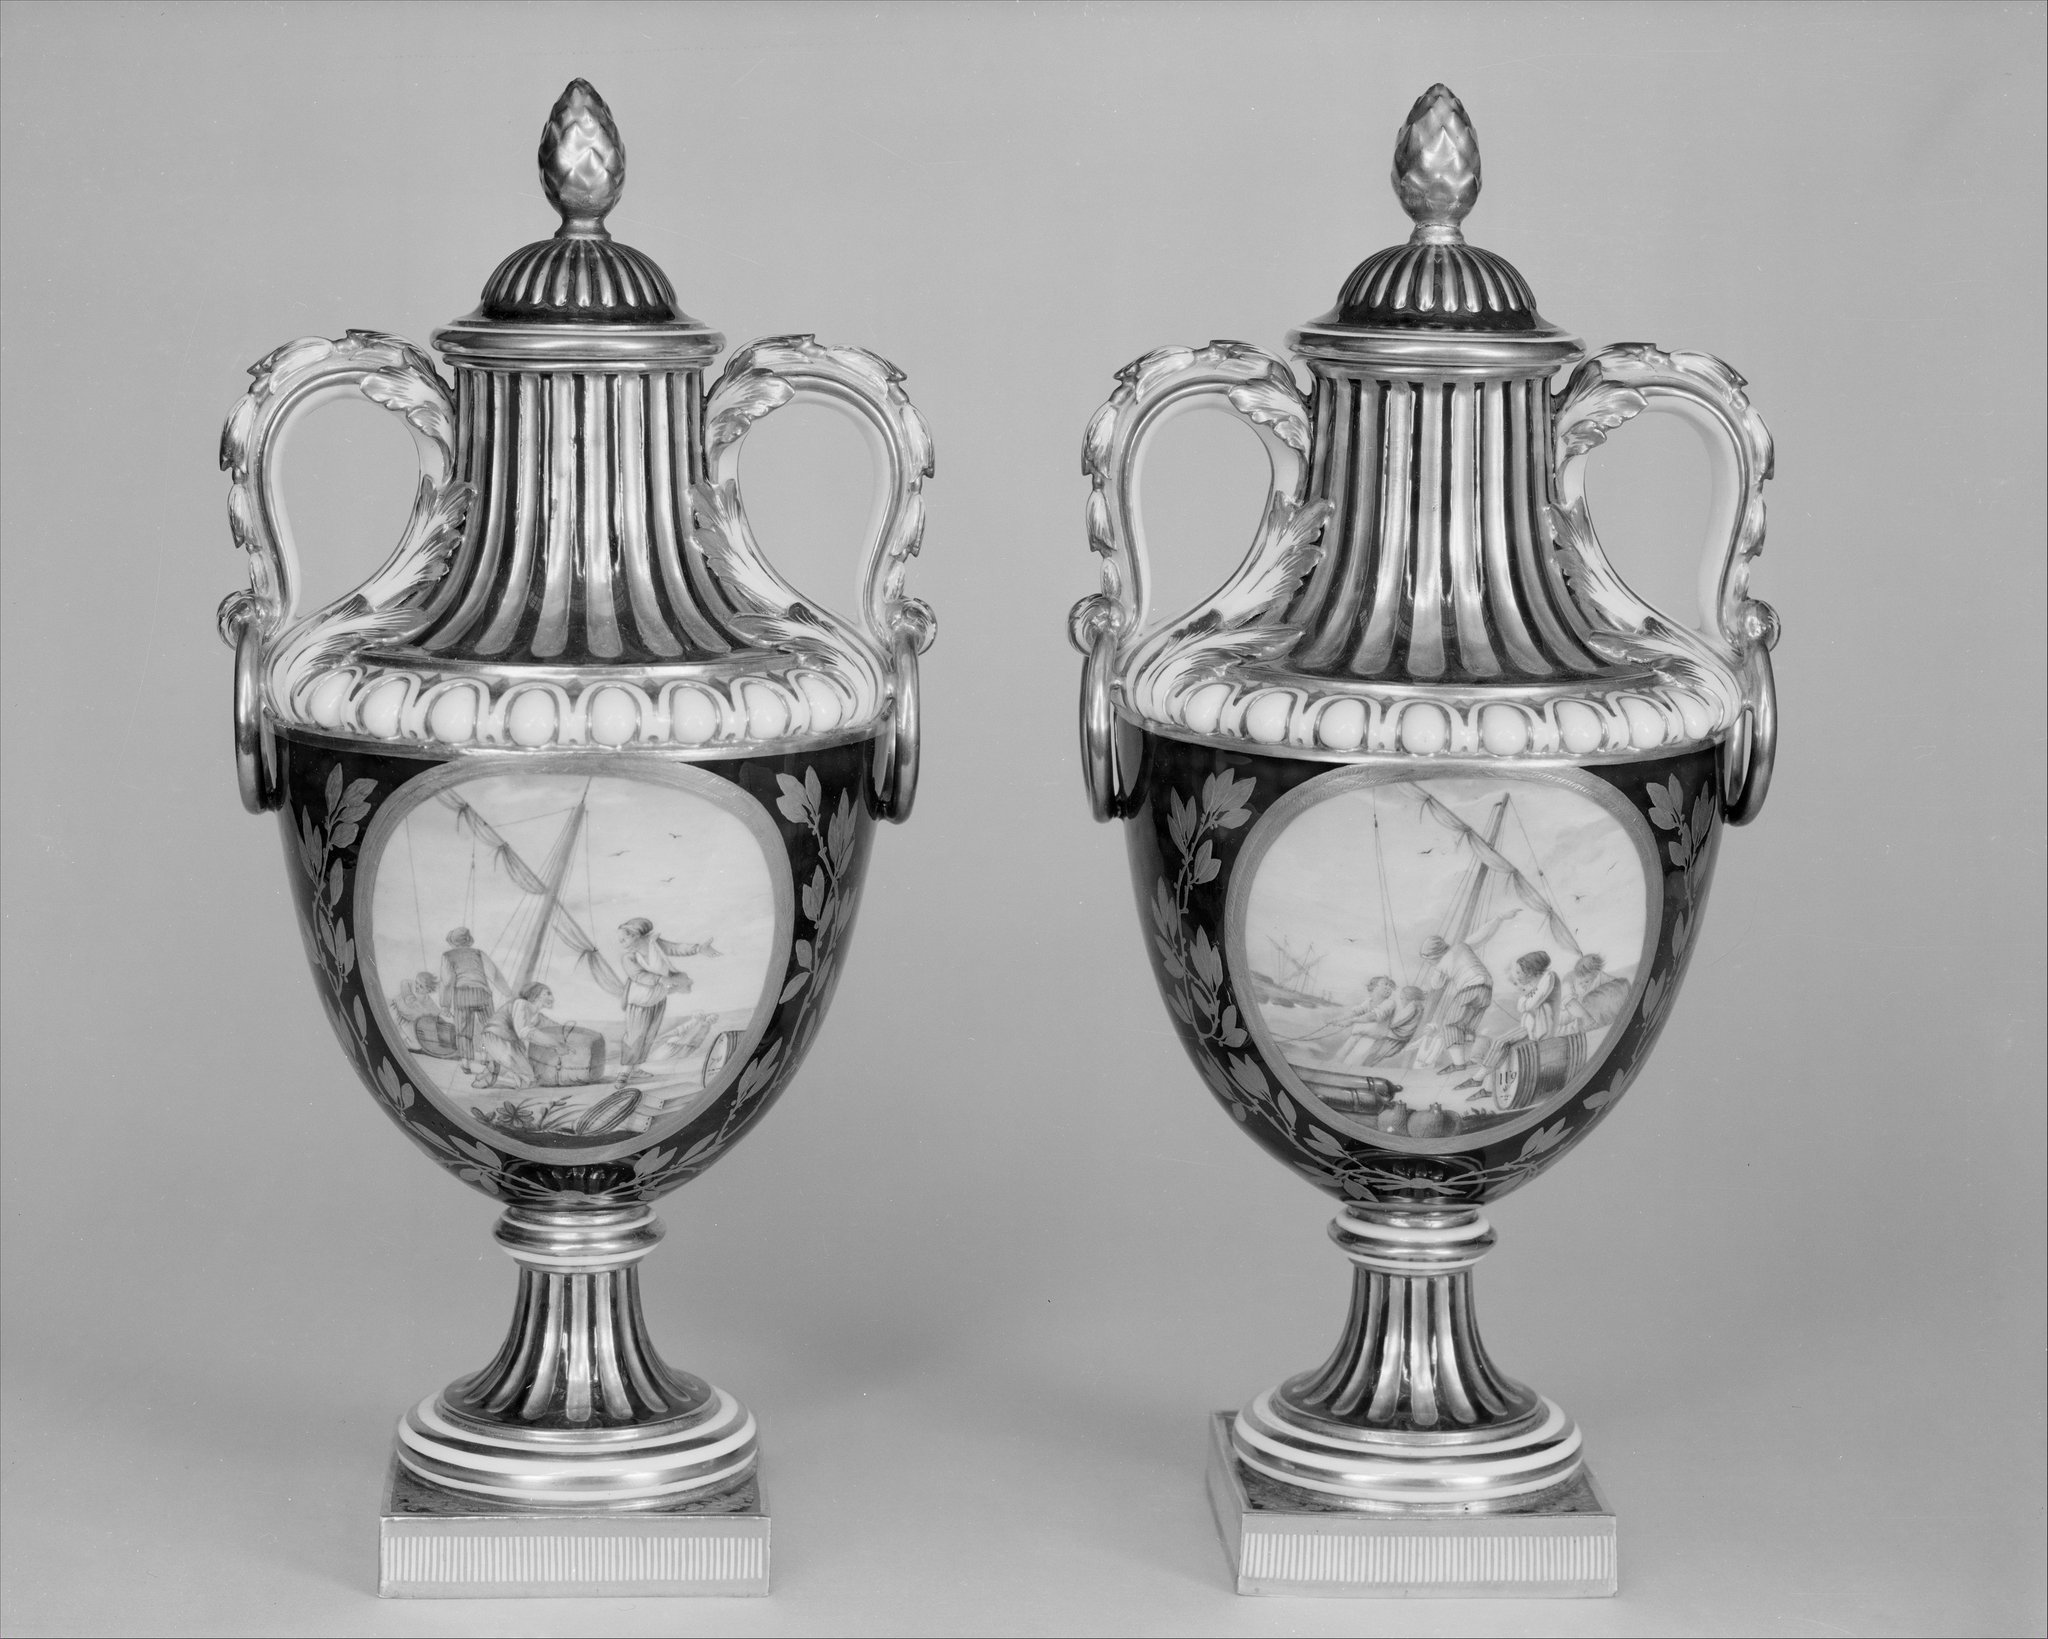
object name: vase with cover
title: Vase with cover (vase de coté de Paris) (one of a pair)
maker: sèvres manufactory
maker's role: manufactory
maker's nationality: french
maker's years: 1740-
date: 1775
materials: soft paste porcelain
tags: men,working